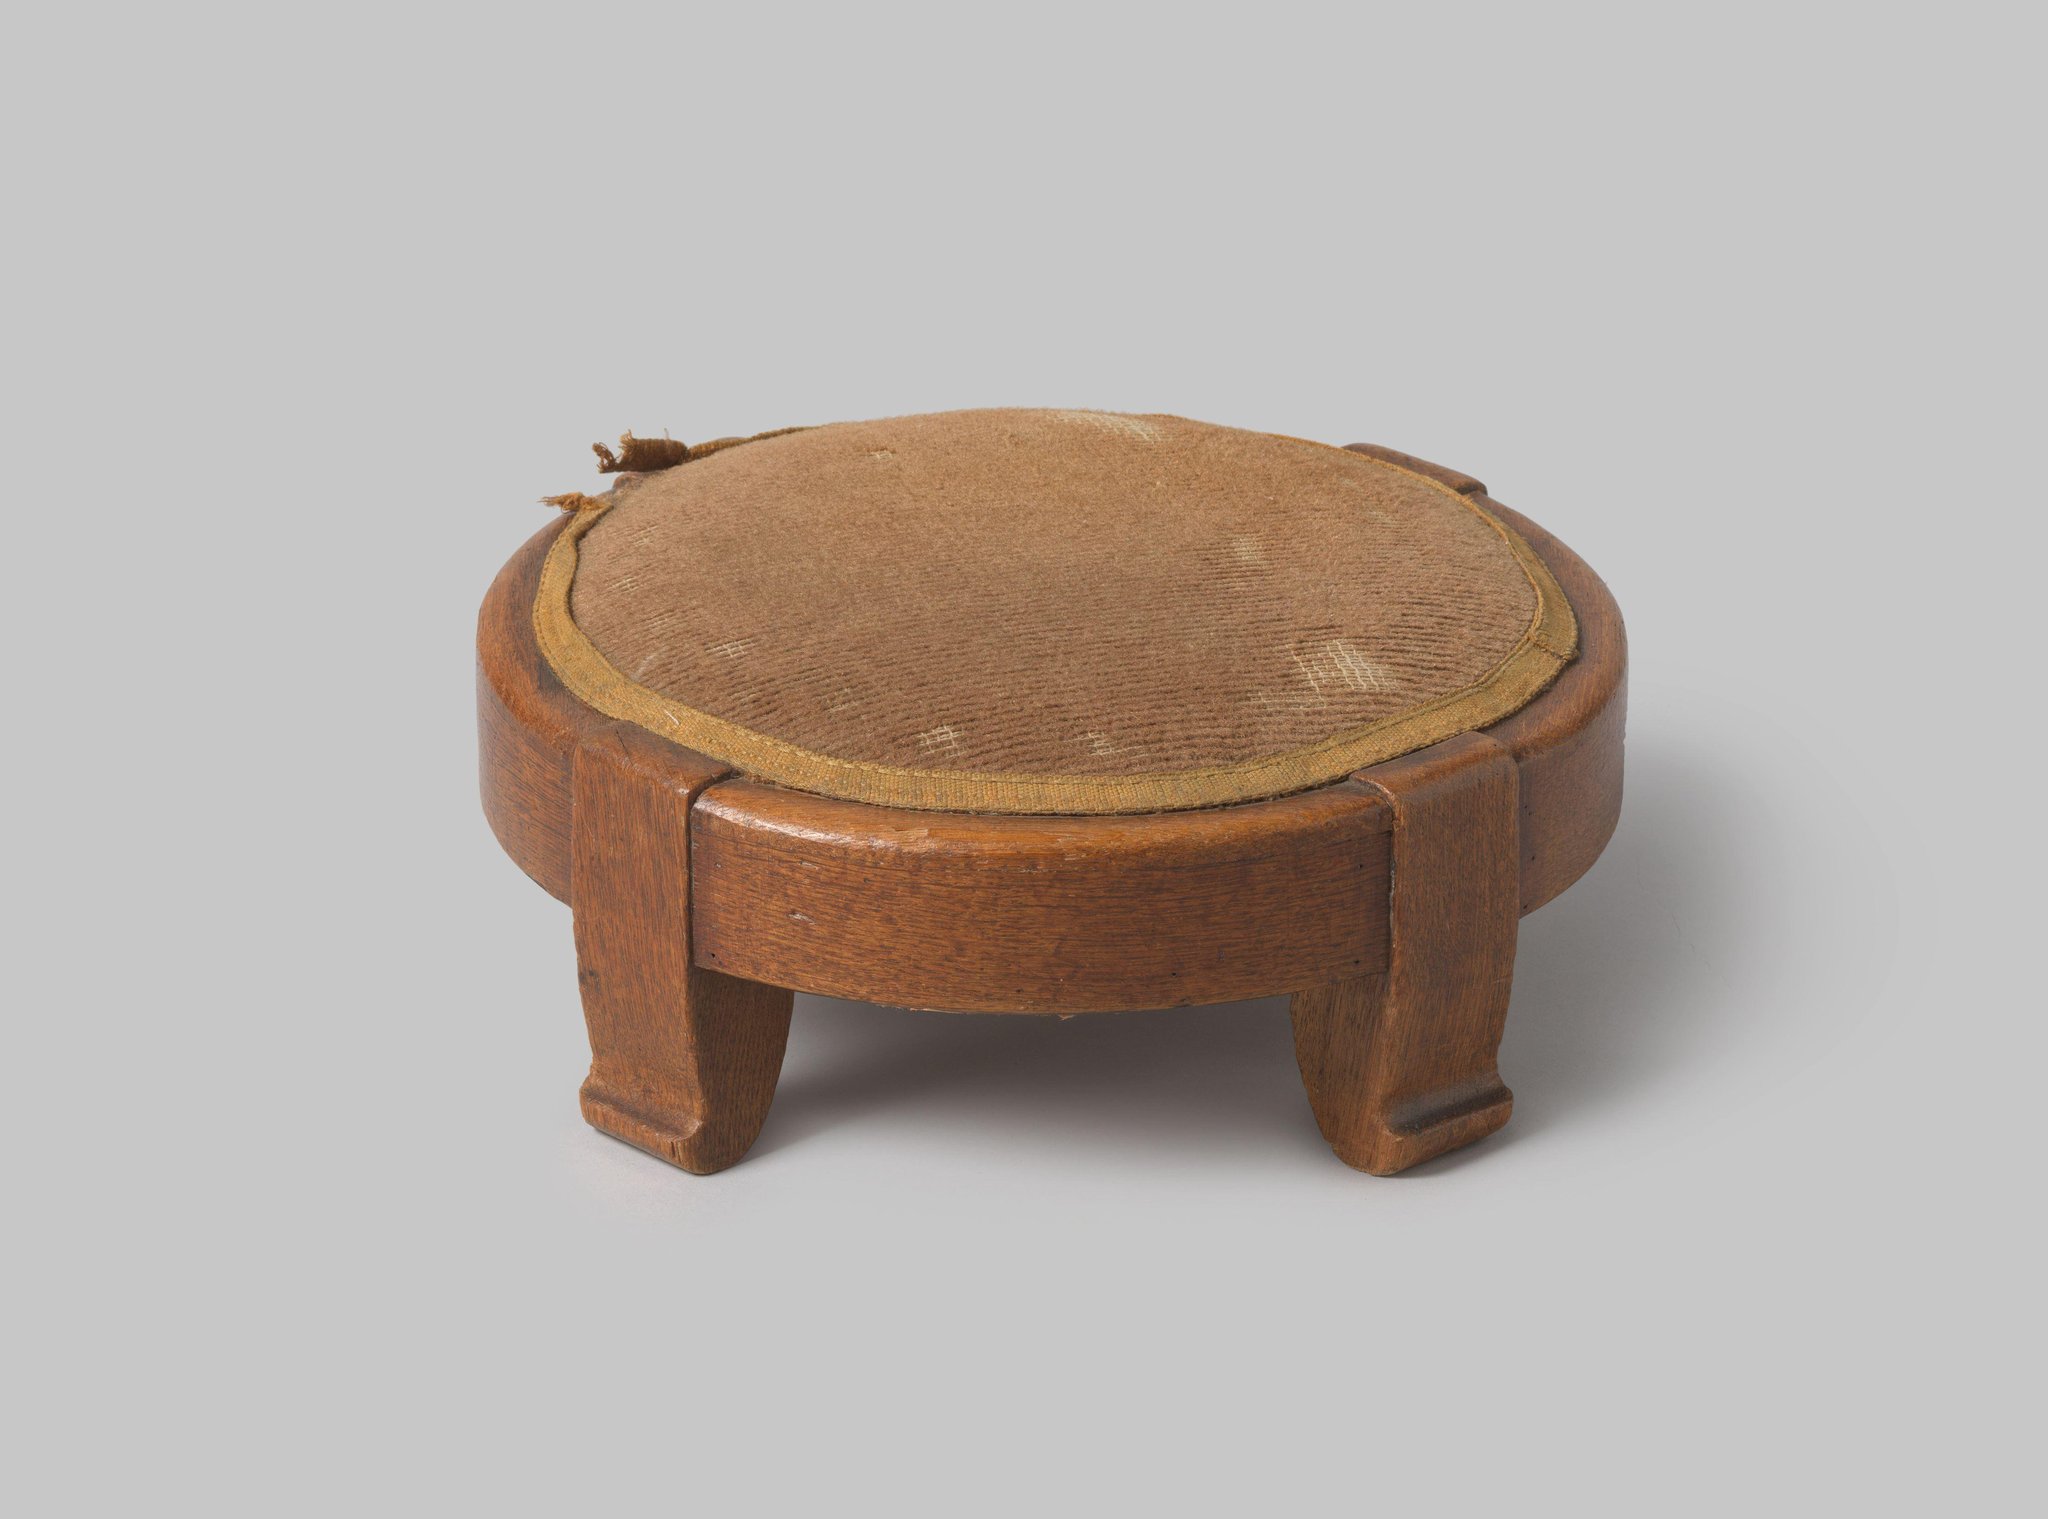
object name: footstool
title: Voetenbank in een ovale vorm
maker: Anonymous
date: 1900-1925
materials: wood, wool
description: Voetenbank vervaardigd van eikenhout in een ovale vorm rustend op vier poten. De vier poten zijn ingelaten in de ovale omlijsting en eindigen aan de onderzijde in een naar buiten gekeerde krul. Binnen de ovale omlijsting is de voetenbank bekleed met bruin trijp dat is afgezet met een bruin-gele band.